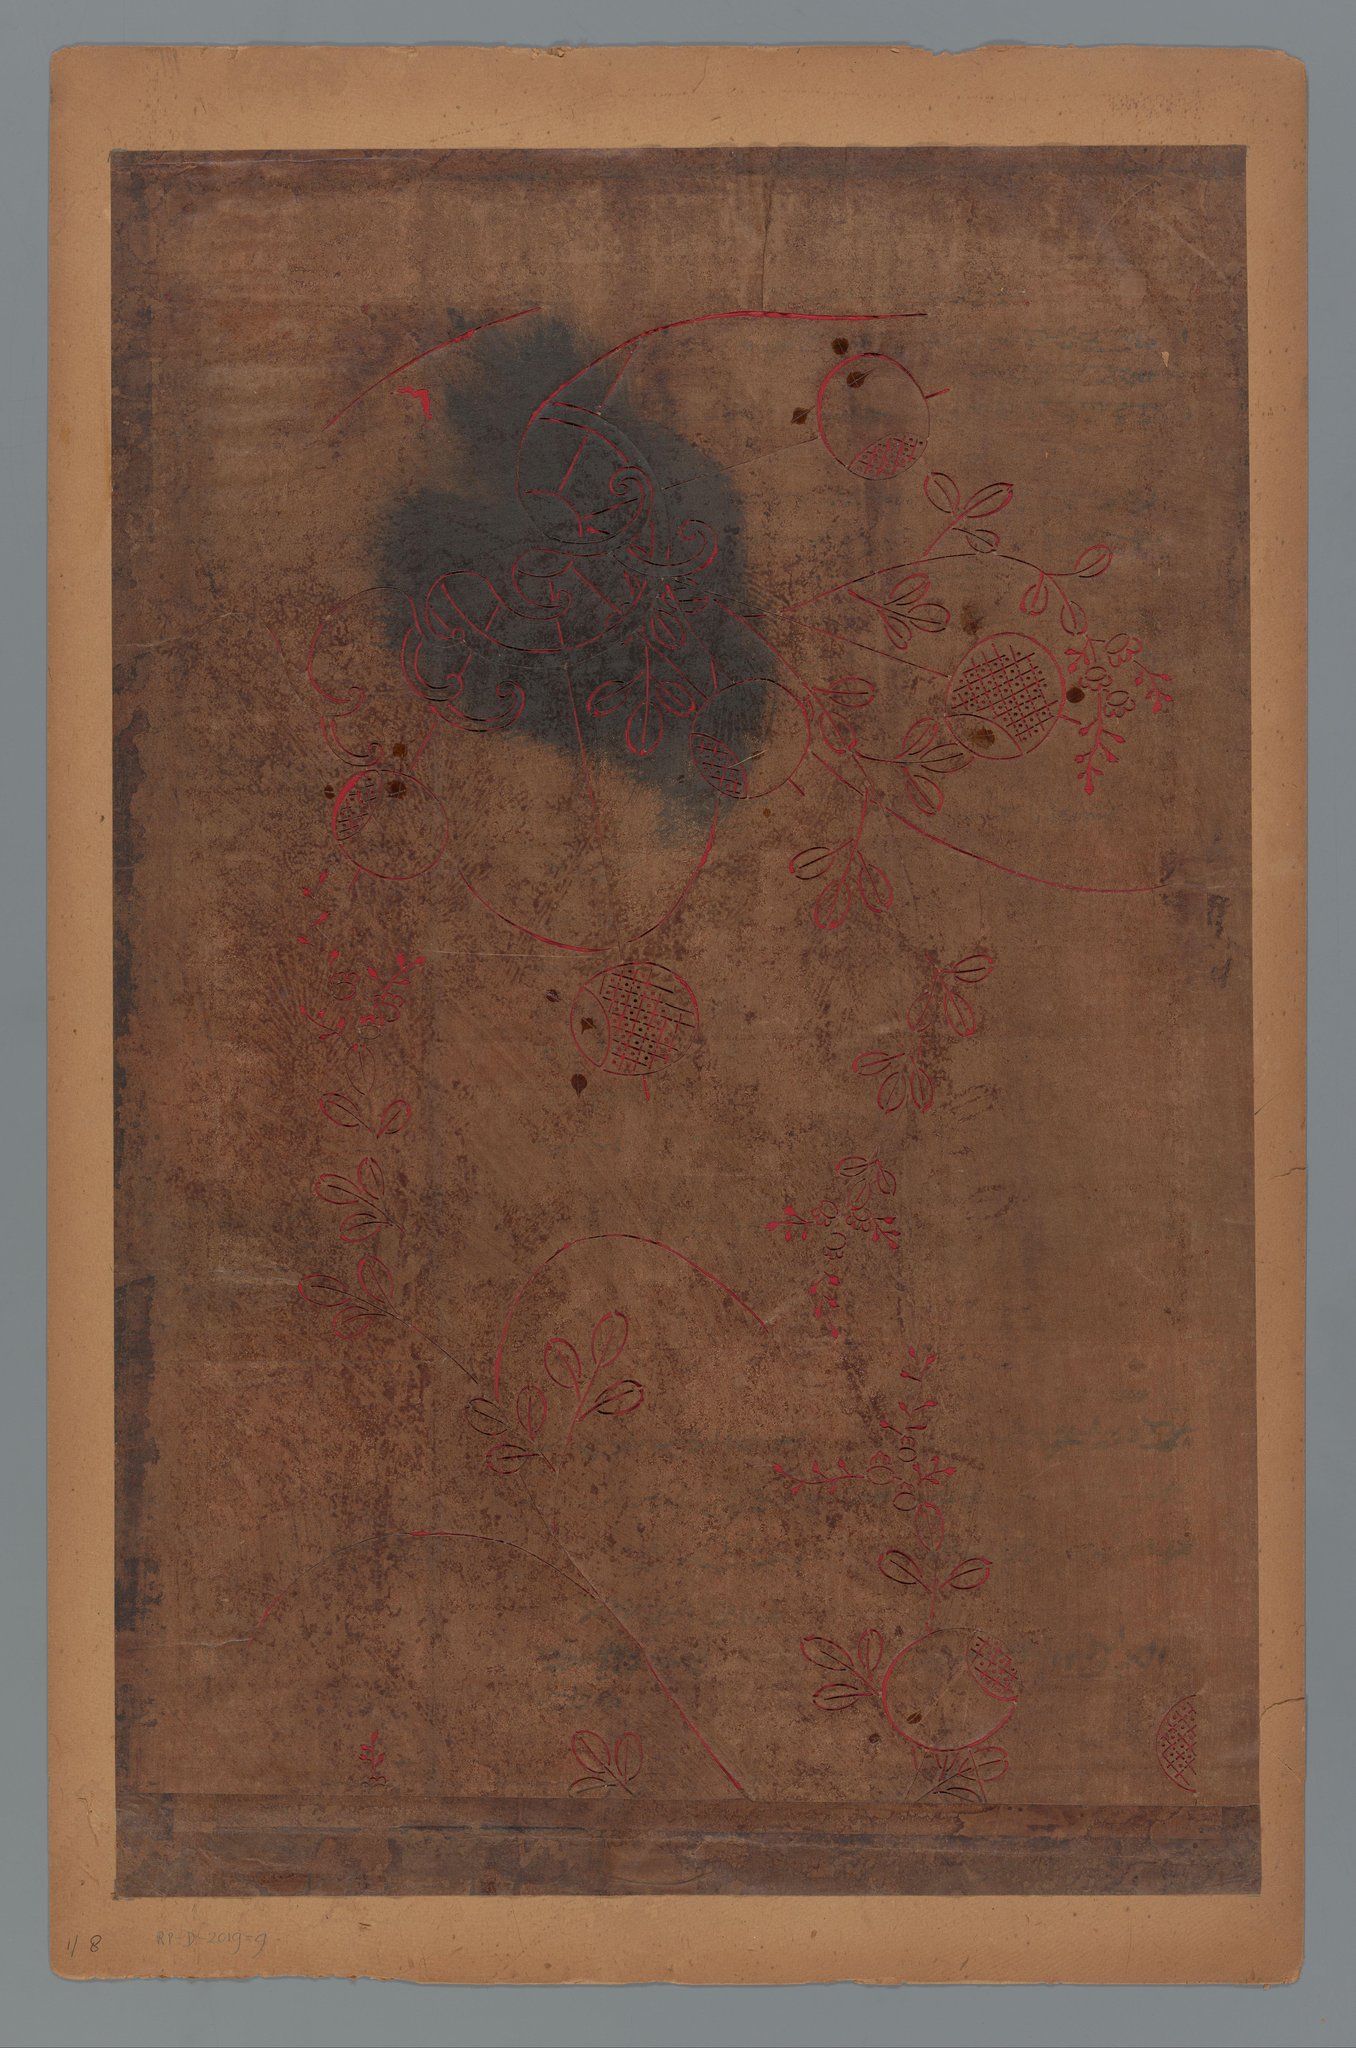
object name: katagami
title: Sjabloon met ingekerfde takken met bloemen en vruchten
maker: Anonymous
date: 1800-1909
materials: paper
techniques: cutting, handwriting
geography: japan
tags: ornament derived from plant forms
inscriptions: stamp: ‘Afgeschreven W...’, number: ‘1/8’, stamp: ‘Museum van Kunstnijverheid Haarlem’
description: Japanse sjabloon (katagami) met een ingekerfd patroon van takken met bloemen en vruchten. Op het blad op meerdere plekken sporen van Japans schrift.